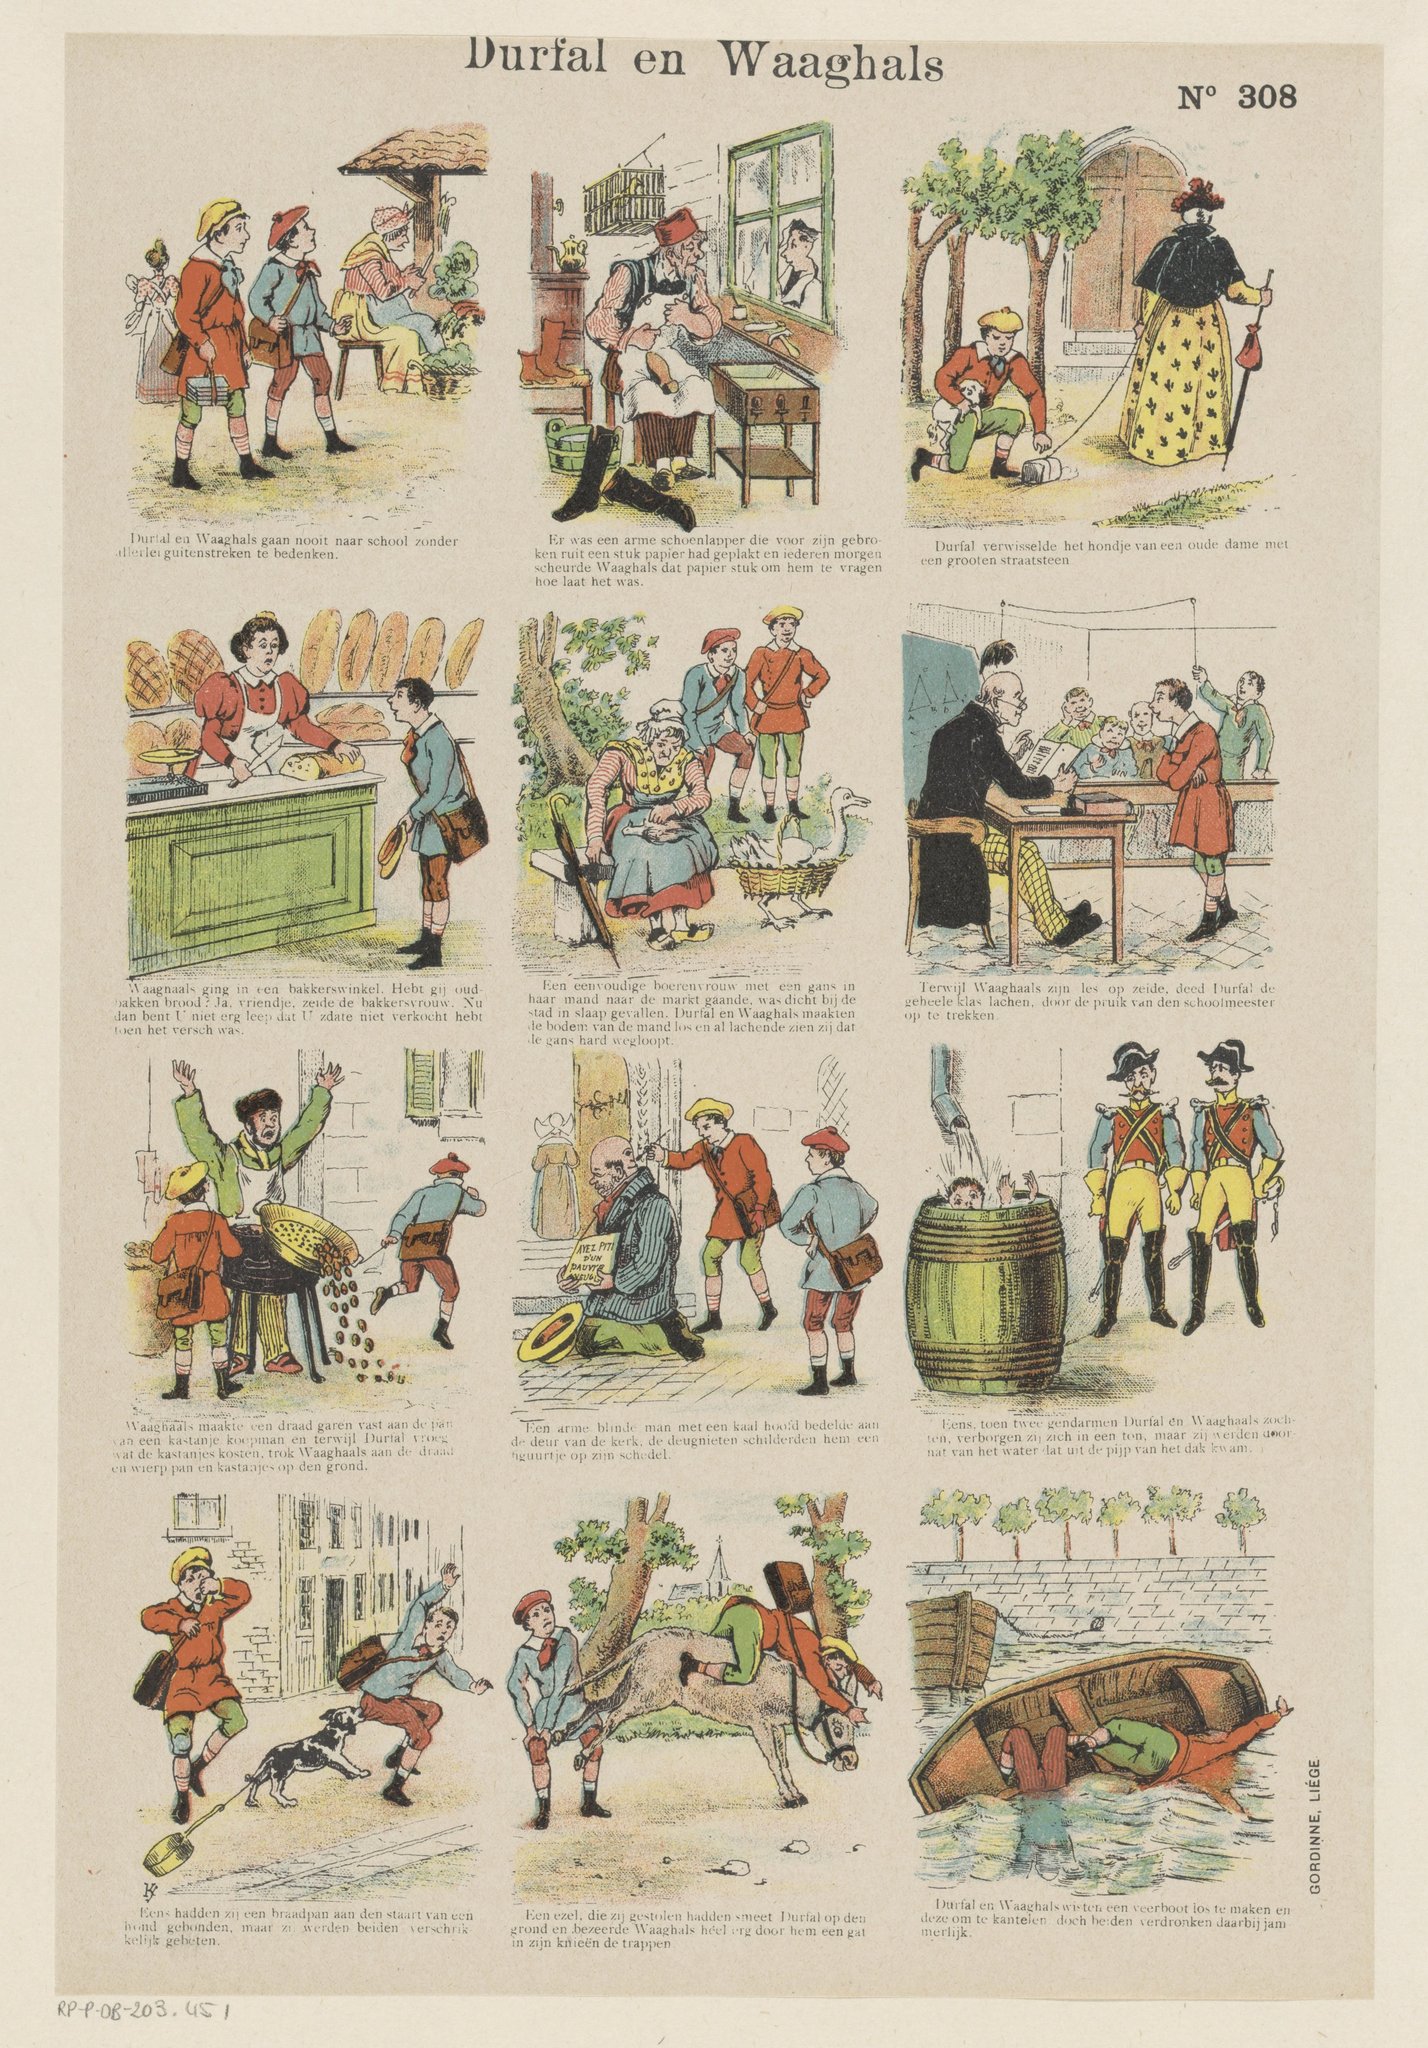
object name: popular print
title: Durfal en Waaghals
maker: Anonymous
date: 1894-1959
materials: paper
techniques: lithograph, letterpress printing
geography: liège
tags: mischief-making play, child, bad behaviour, death by drowning (non-violent), comedy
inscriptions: collector's mark: Lugt 2760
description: Blad met 12 voorstellingen over de twee kwajongens Durfal en Waaghals die streken uithalen. Uiteindelijk verdrinken ze tijdens een van hun streken. Onder elke afbeelding een onderschrift. Genummerd rechtsboven: No 308.